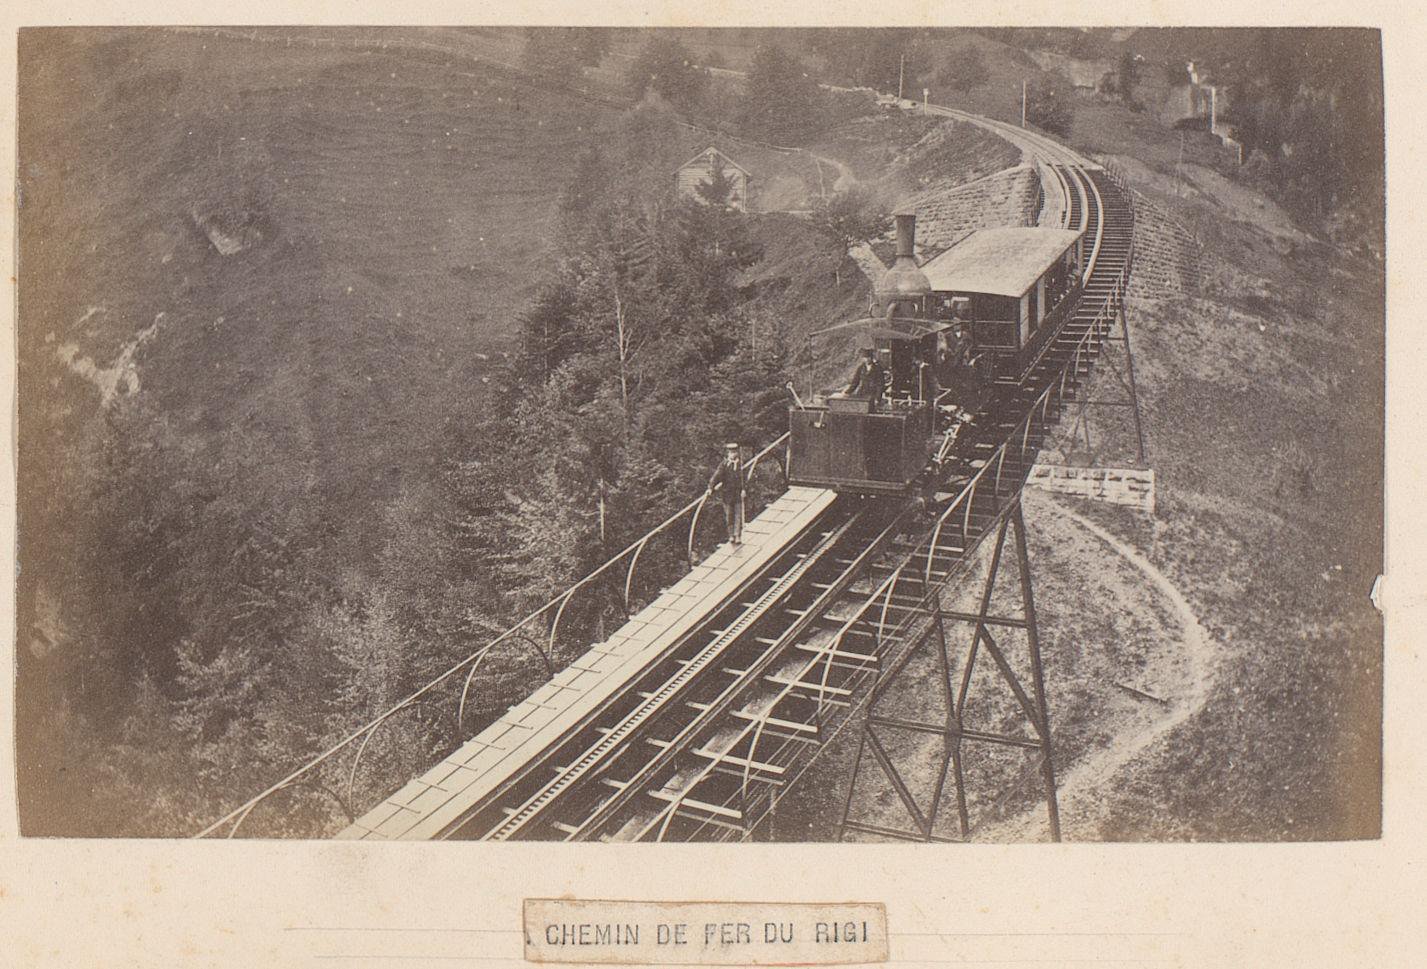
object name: album leaf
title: Chemin de fer du Rigi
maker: Anonymous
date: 1871-1890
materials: paper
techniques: albumen print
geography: rigi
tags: rack railway